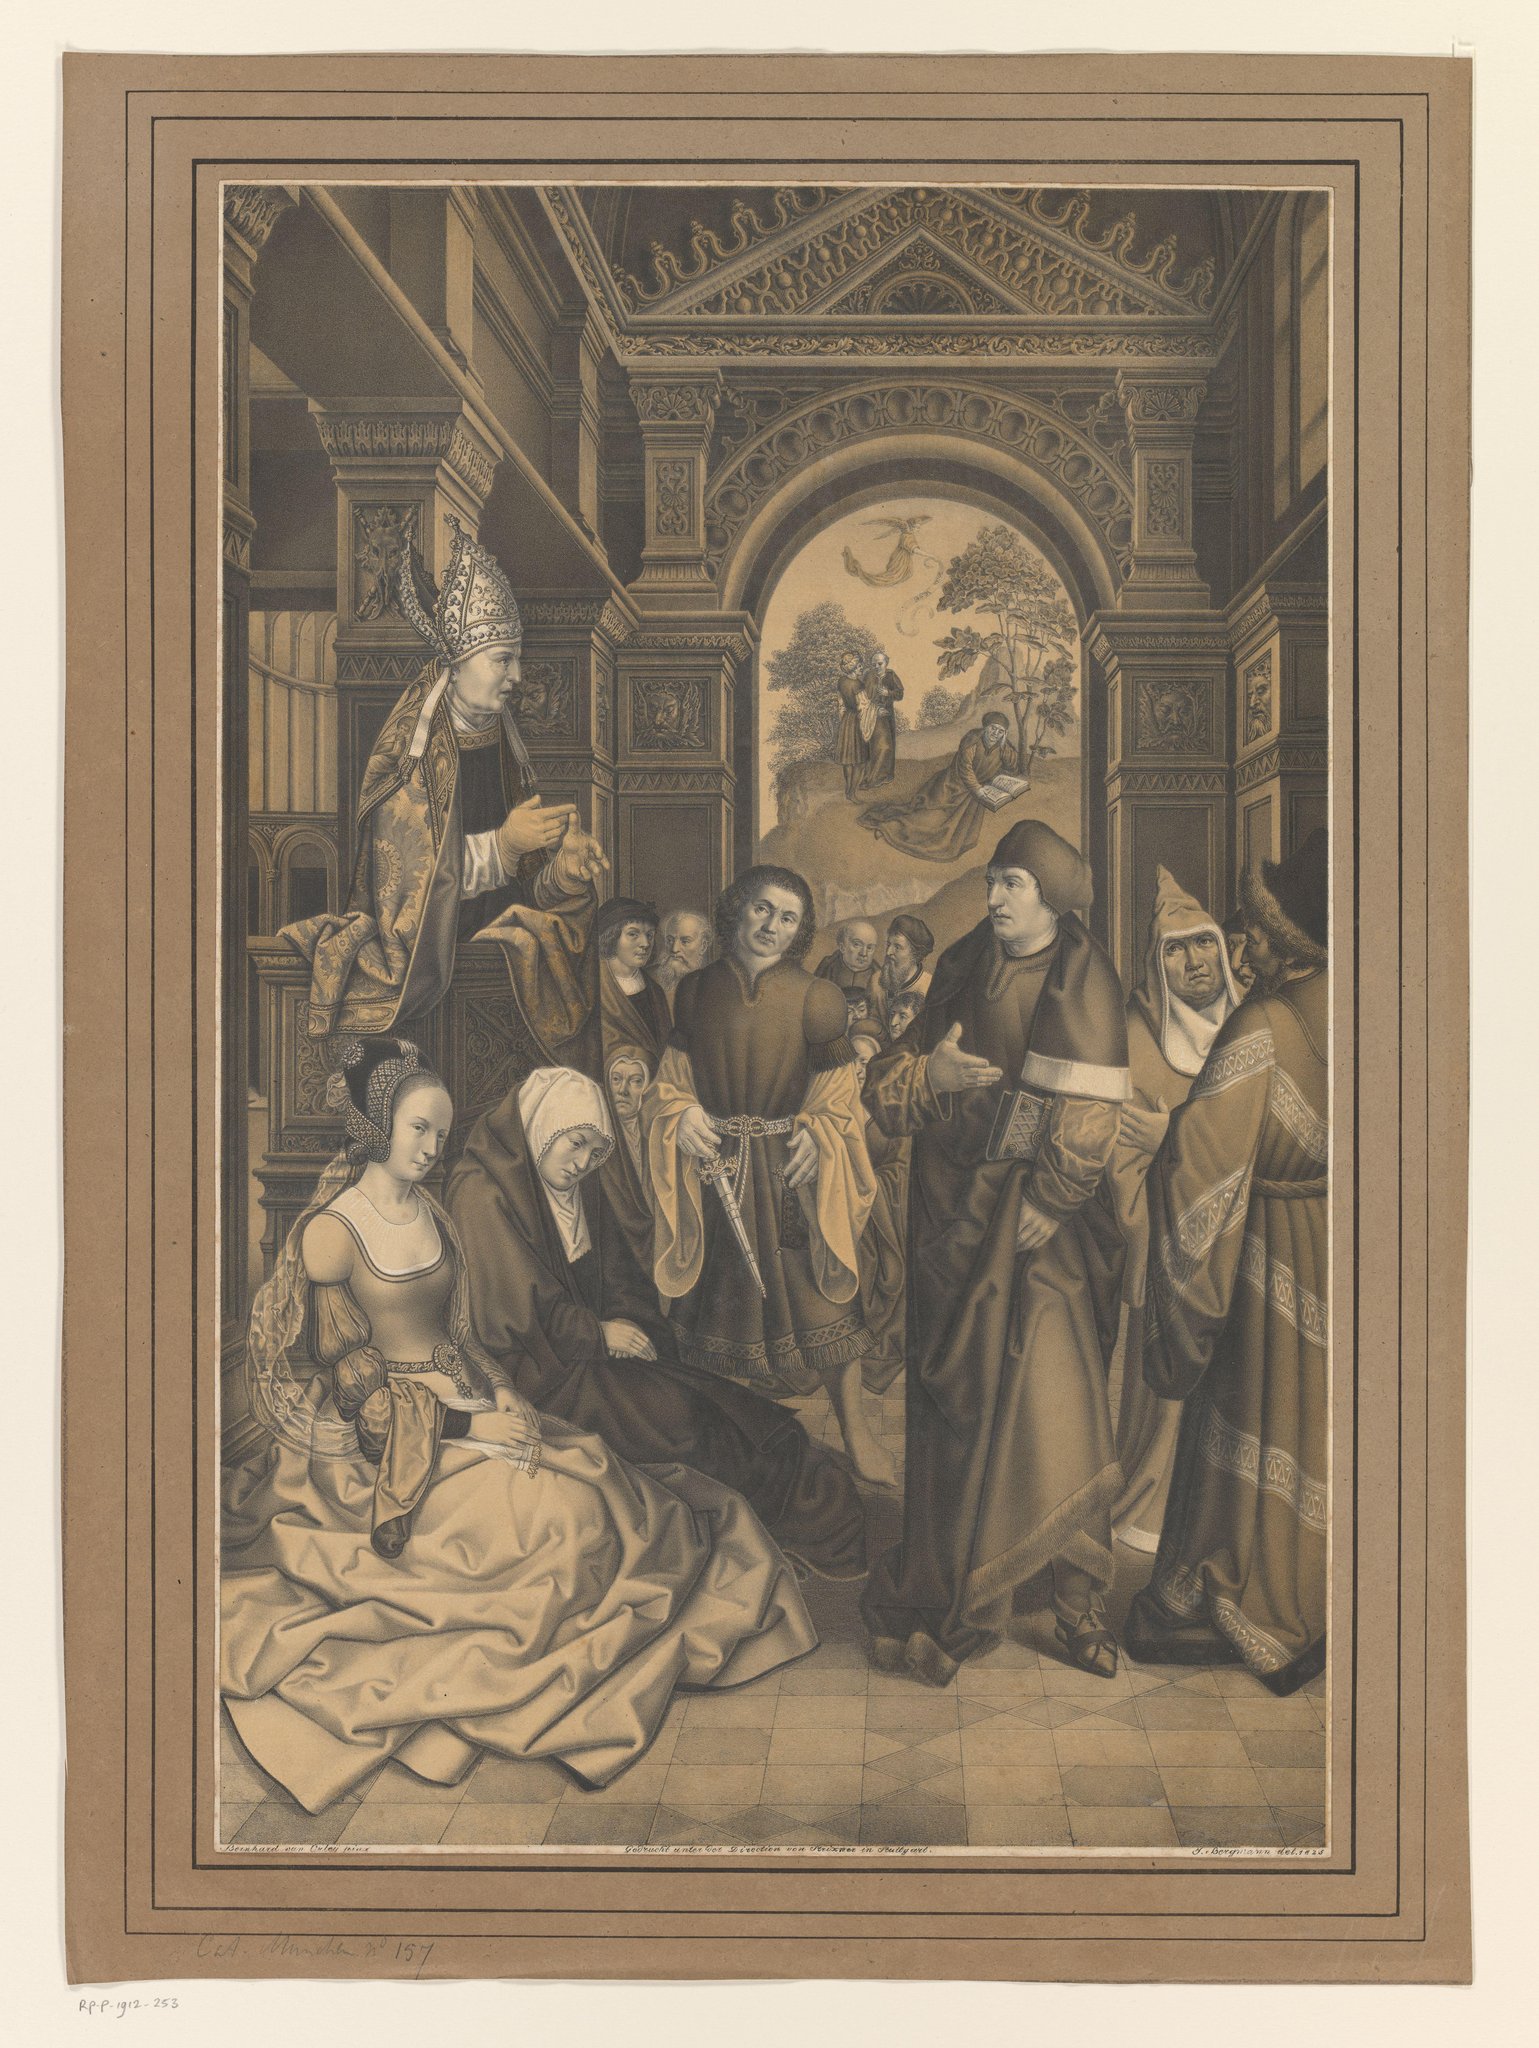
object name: print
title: Werken uit de collectie van de broers Boisserée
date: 1825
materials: paper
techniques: tone lithography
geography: stuttgart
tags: st. norbert trampling the heretic tankelin, the founder of the praemonstratensians, and archbishop of magdeburg, norbert; possible attributes: chalice (with spider), devil under feet, monstrance, the heretic tankelin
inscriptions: collector's mark: Lugt 2228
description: Deze prent behoort tot de serie 'Galerie des Frères Boisserée'. De serie is in 38 delen uitgegeven met drie prenten per deel en nog drie extra inleidende prenten. Deze prent verscheen in het veertiende deel.